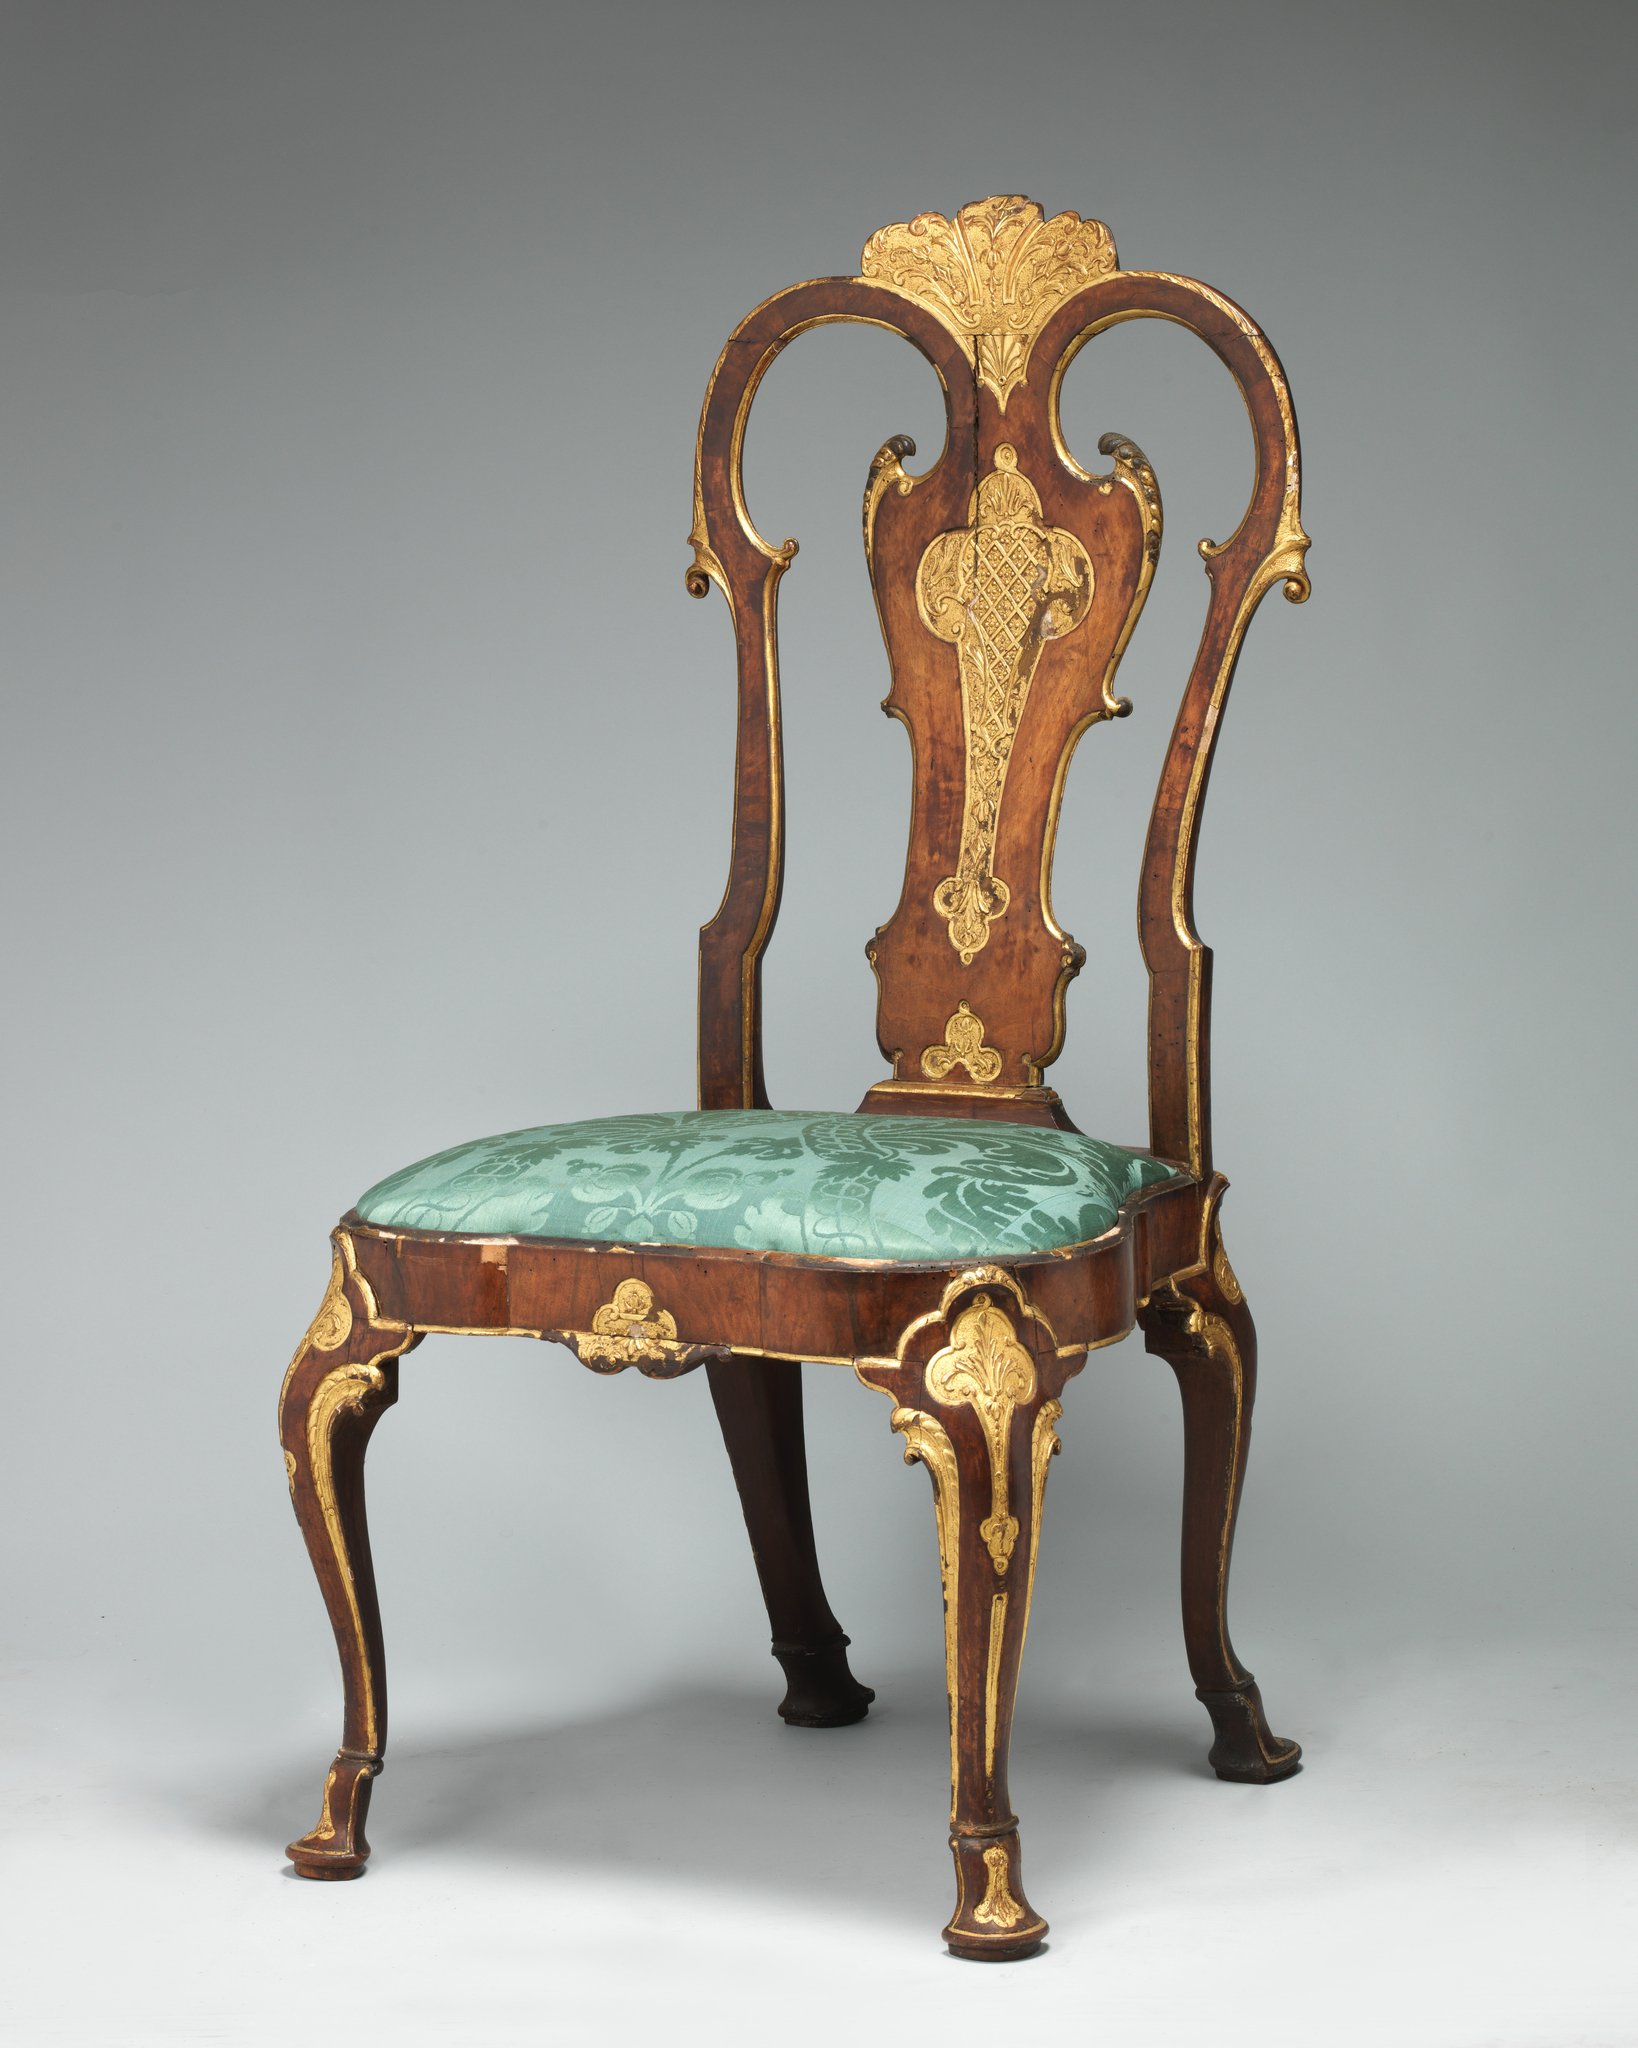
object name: side chair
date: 1720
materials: gesso, gilt, wood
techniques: veneering